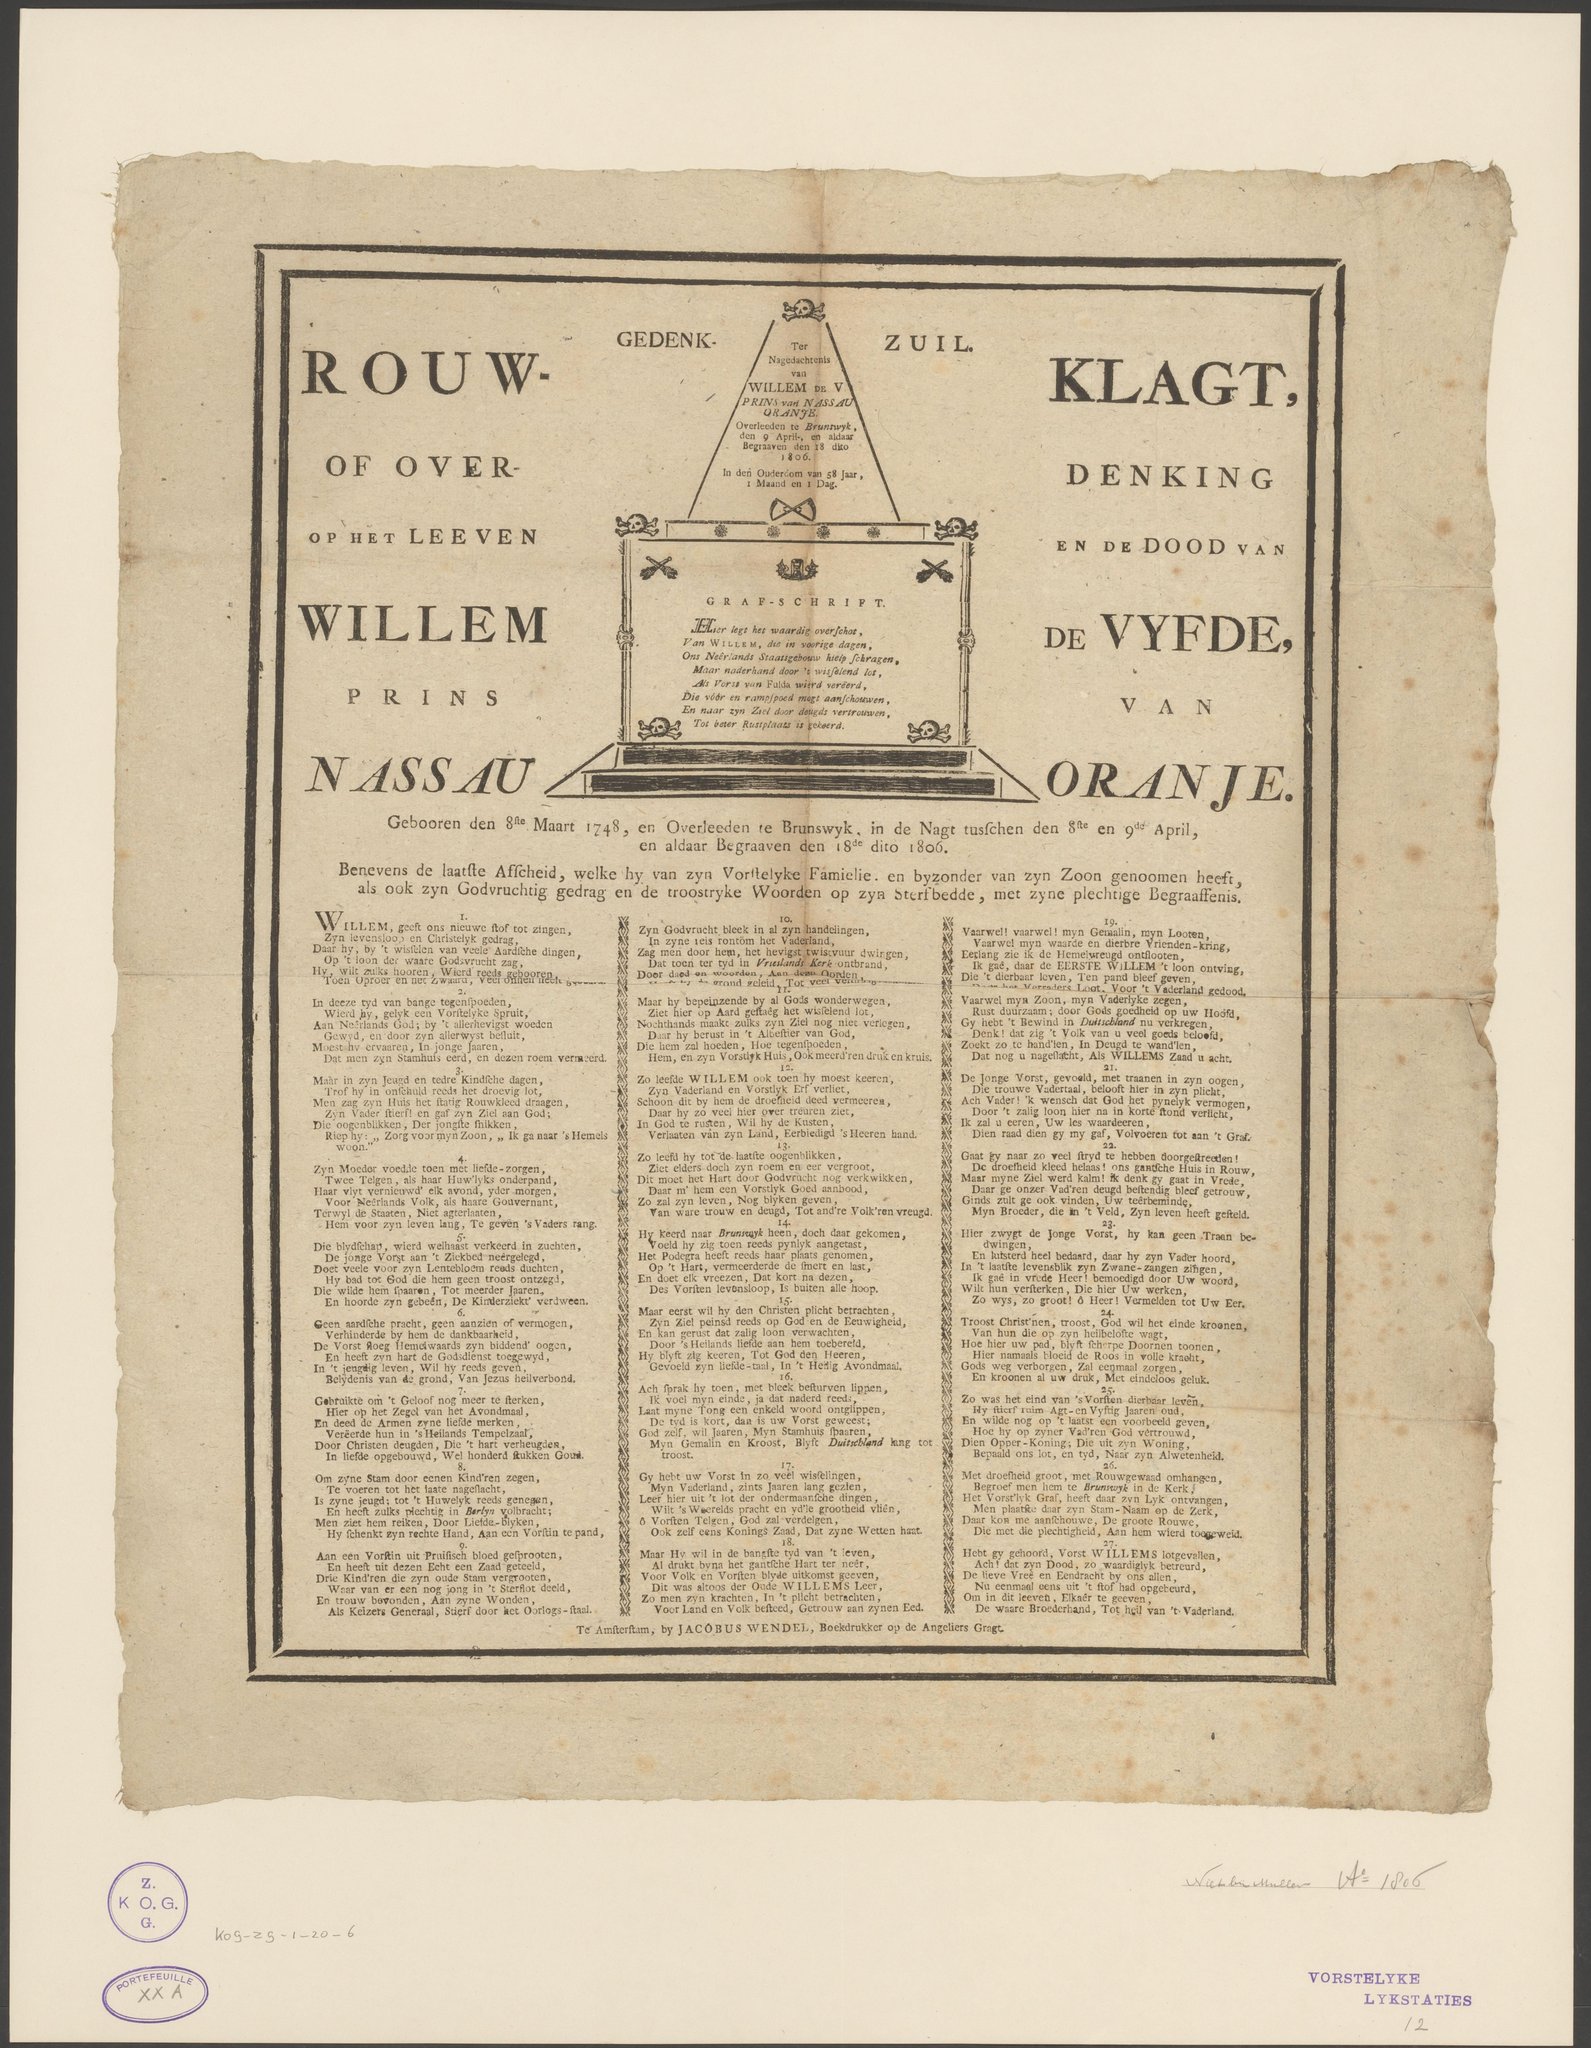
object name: print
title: Rouwklacht bij het overlijden van Willem V, 1806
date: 1806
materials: paper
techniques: letterpress printing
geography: amsterdam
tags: the hague, william v (prince of orange), monument, statue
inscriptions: collector's mark: Lugt 1641, stamp, stamp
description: Rouwklacht op het overlijden van prins Willem V op 9 april 1806. Bovenaan een gedenkzuil met grafschrift. Rouwvers in 27 coupletten in drie kolommen. Binnen een dubbele rouwrand. Onderwerpsrubrieken binnen de Atlas Zeden en Gewoonten: Zeden en Gewoonten in Engeren Zin, Des menschen beging, midden en einde, Vorstelijke lijkstaties.